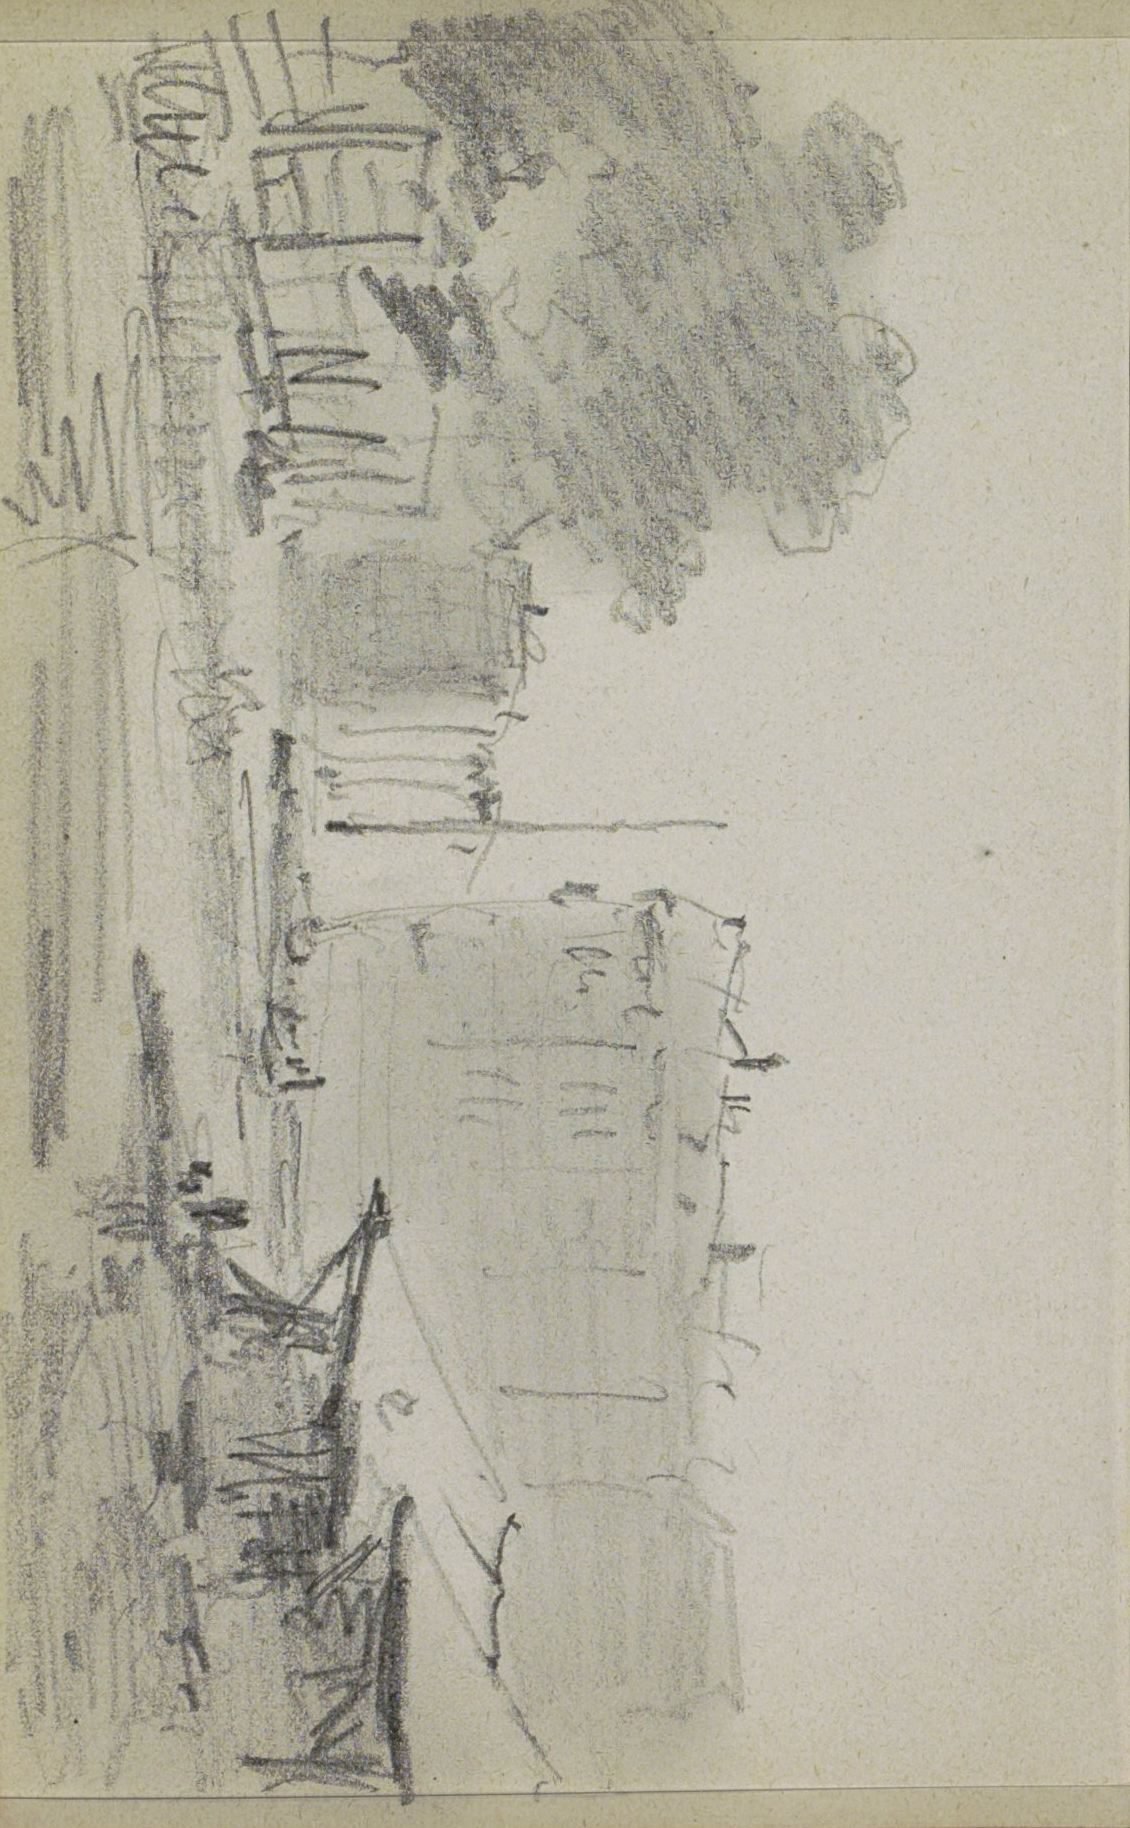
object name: sketchbook leaf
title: Gezicht op gebouwen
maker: adrianus eversen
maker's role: draughtsman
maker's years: 1818-1897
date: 1828-1897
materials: paper, pencil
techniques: stumping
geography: netherlands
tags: civic architecture; edifices; dwellings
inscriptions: kleurnotitie, handgeschreven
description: Gezicht op gebouwen, waarschijnlijk aan het water. In het midden mogelijk een zeilschip. Blad 36 verso uit een schetsboek met 58 bladen.